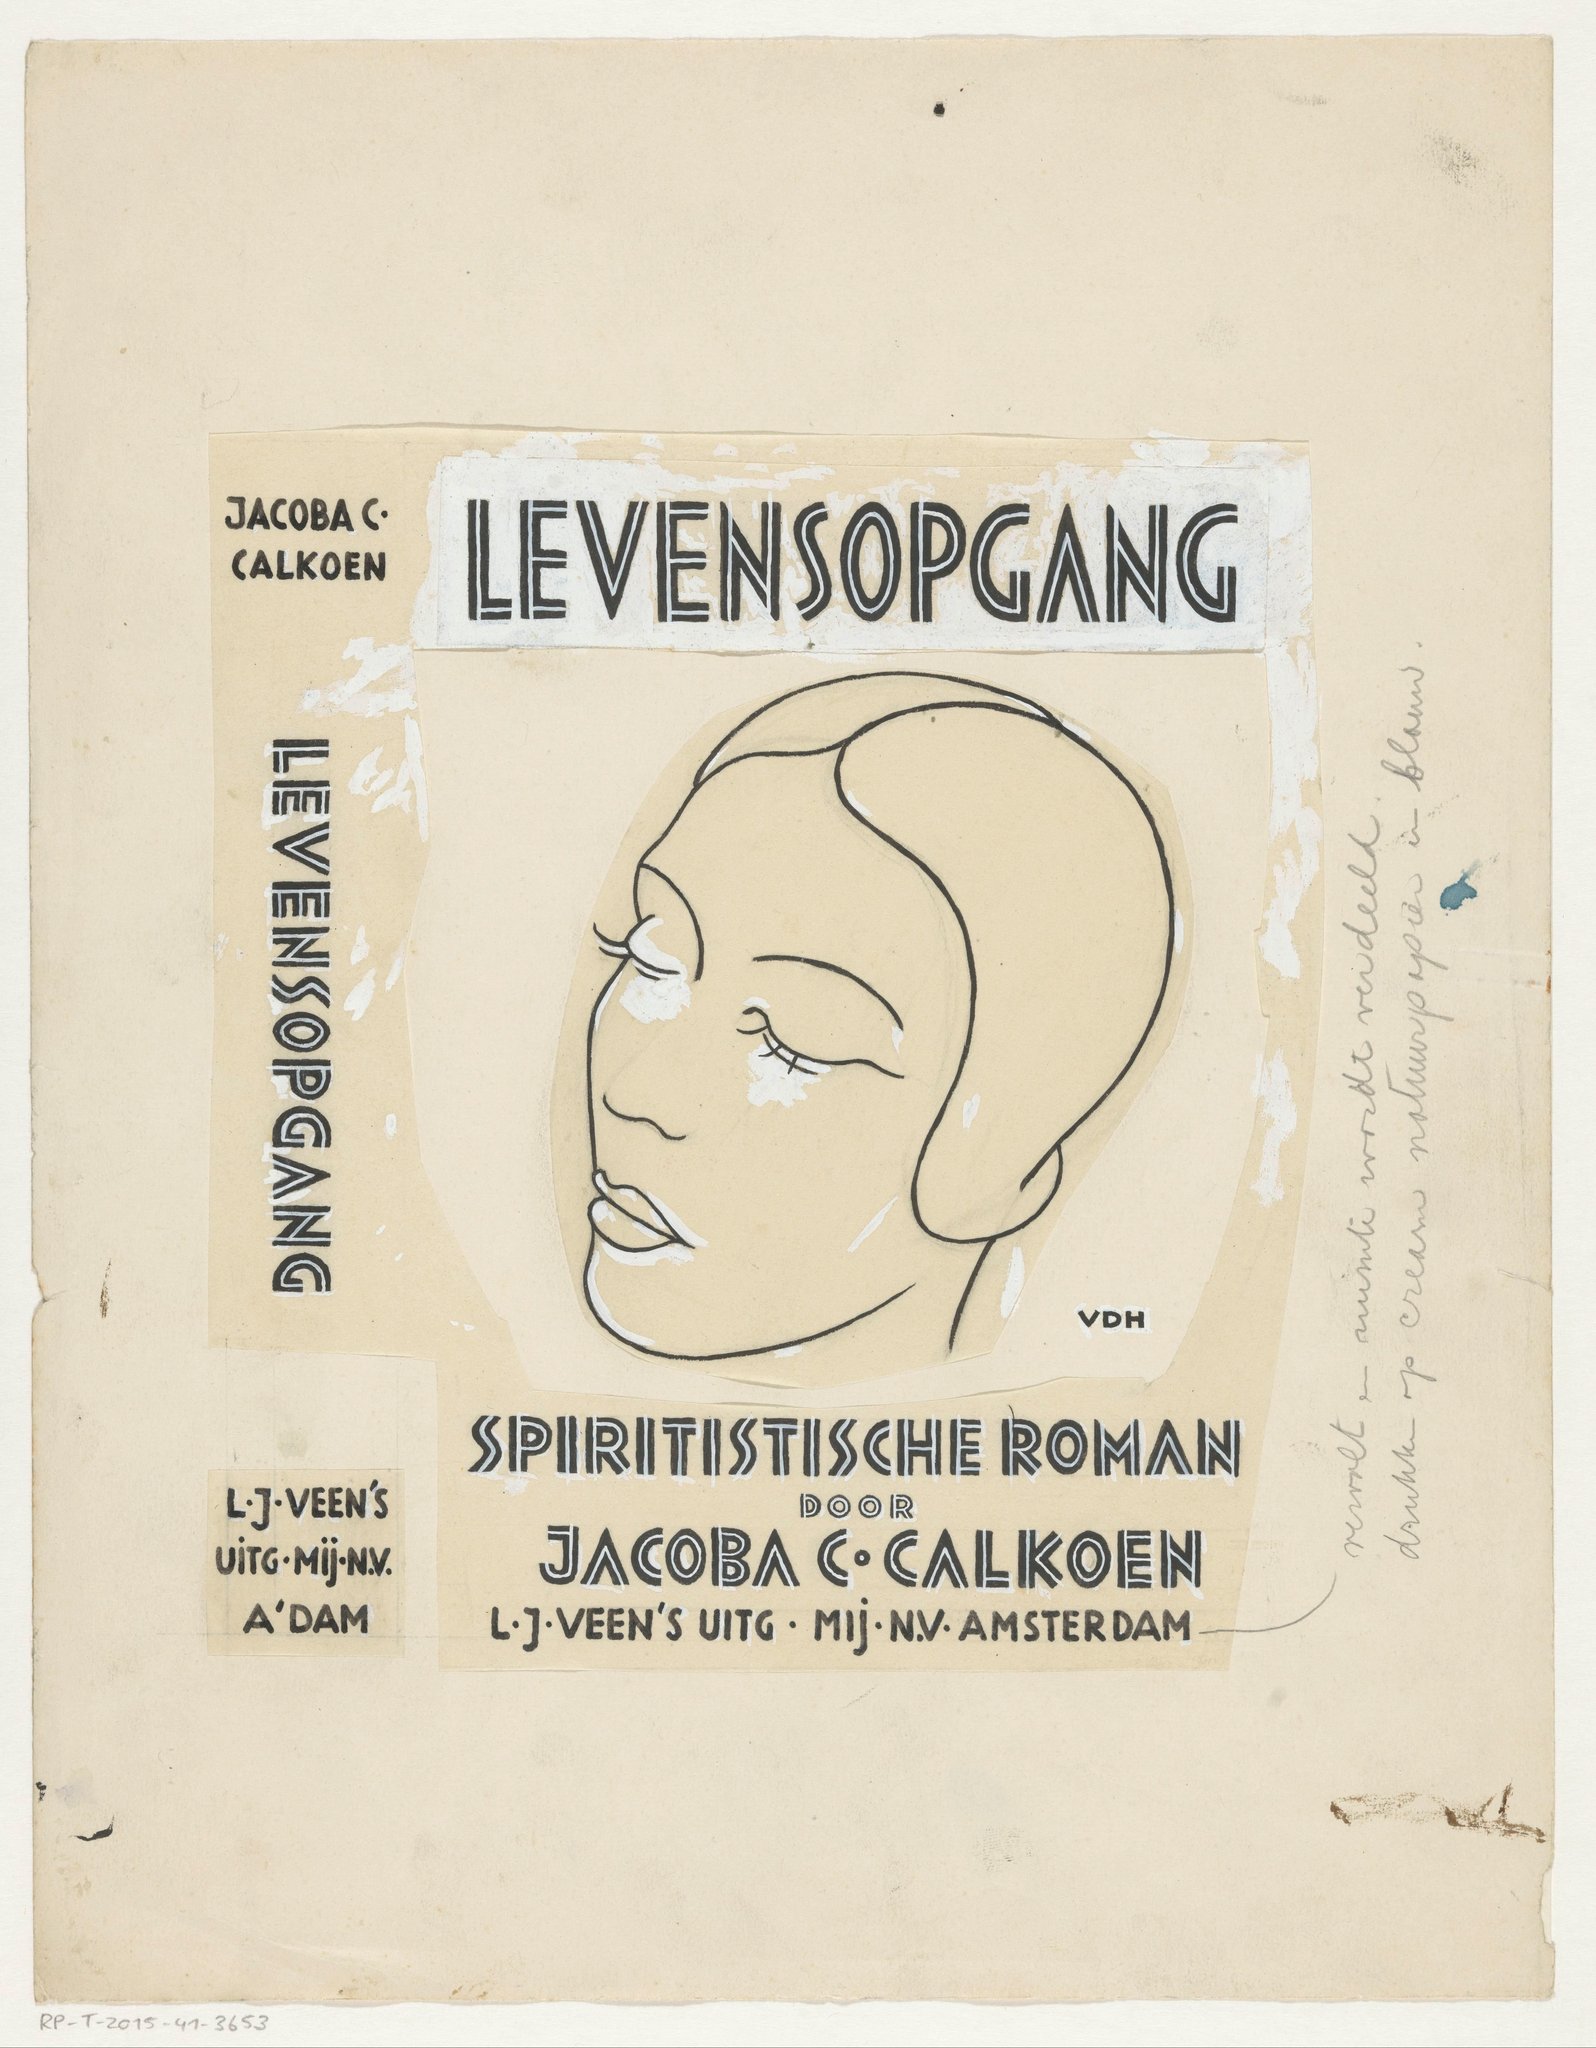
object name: study for binding design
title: Bandontwerp voor: Jacoba C. Calkoen, Levensopgang. Spiritistische roman, 1933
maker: Anonymous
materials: paint, paper, pencil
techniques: brush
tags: eyes closed, head (human) - aa - female human figure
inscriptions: collector's mark: Lugt 2228a, signature: ‘VDH’, :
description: Hoofd van een vrouw met kort haar en gesloten ogen.